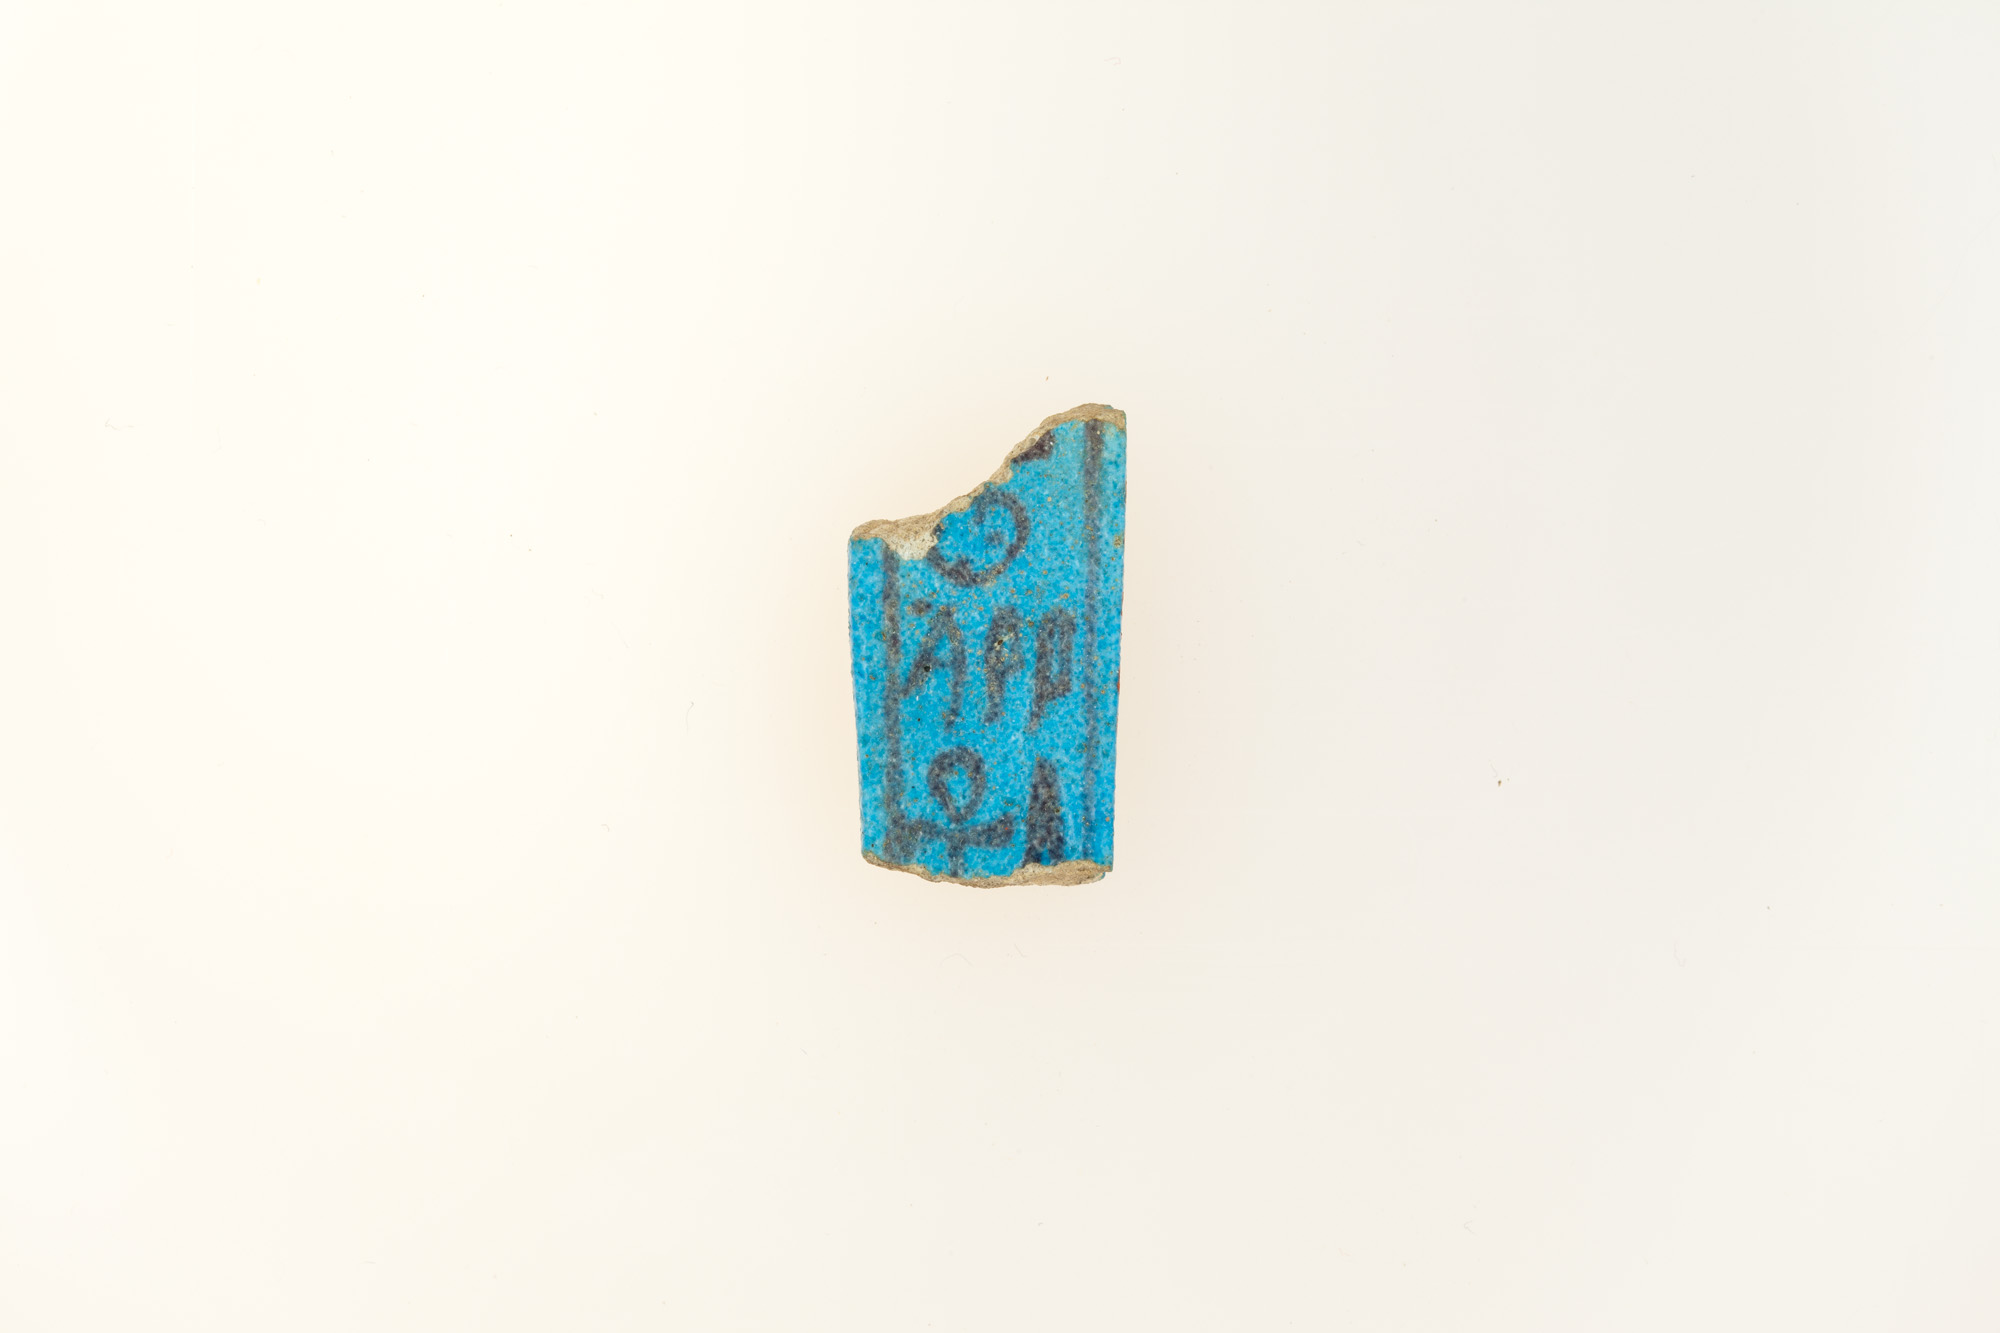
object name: menat fragment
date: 1479-1458 BCE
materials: faience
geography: egypt